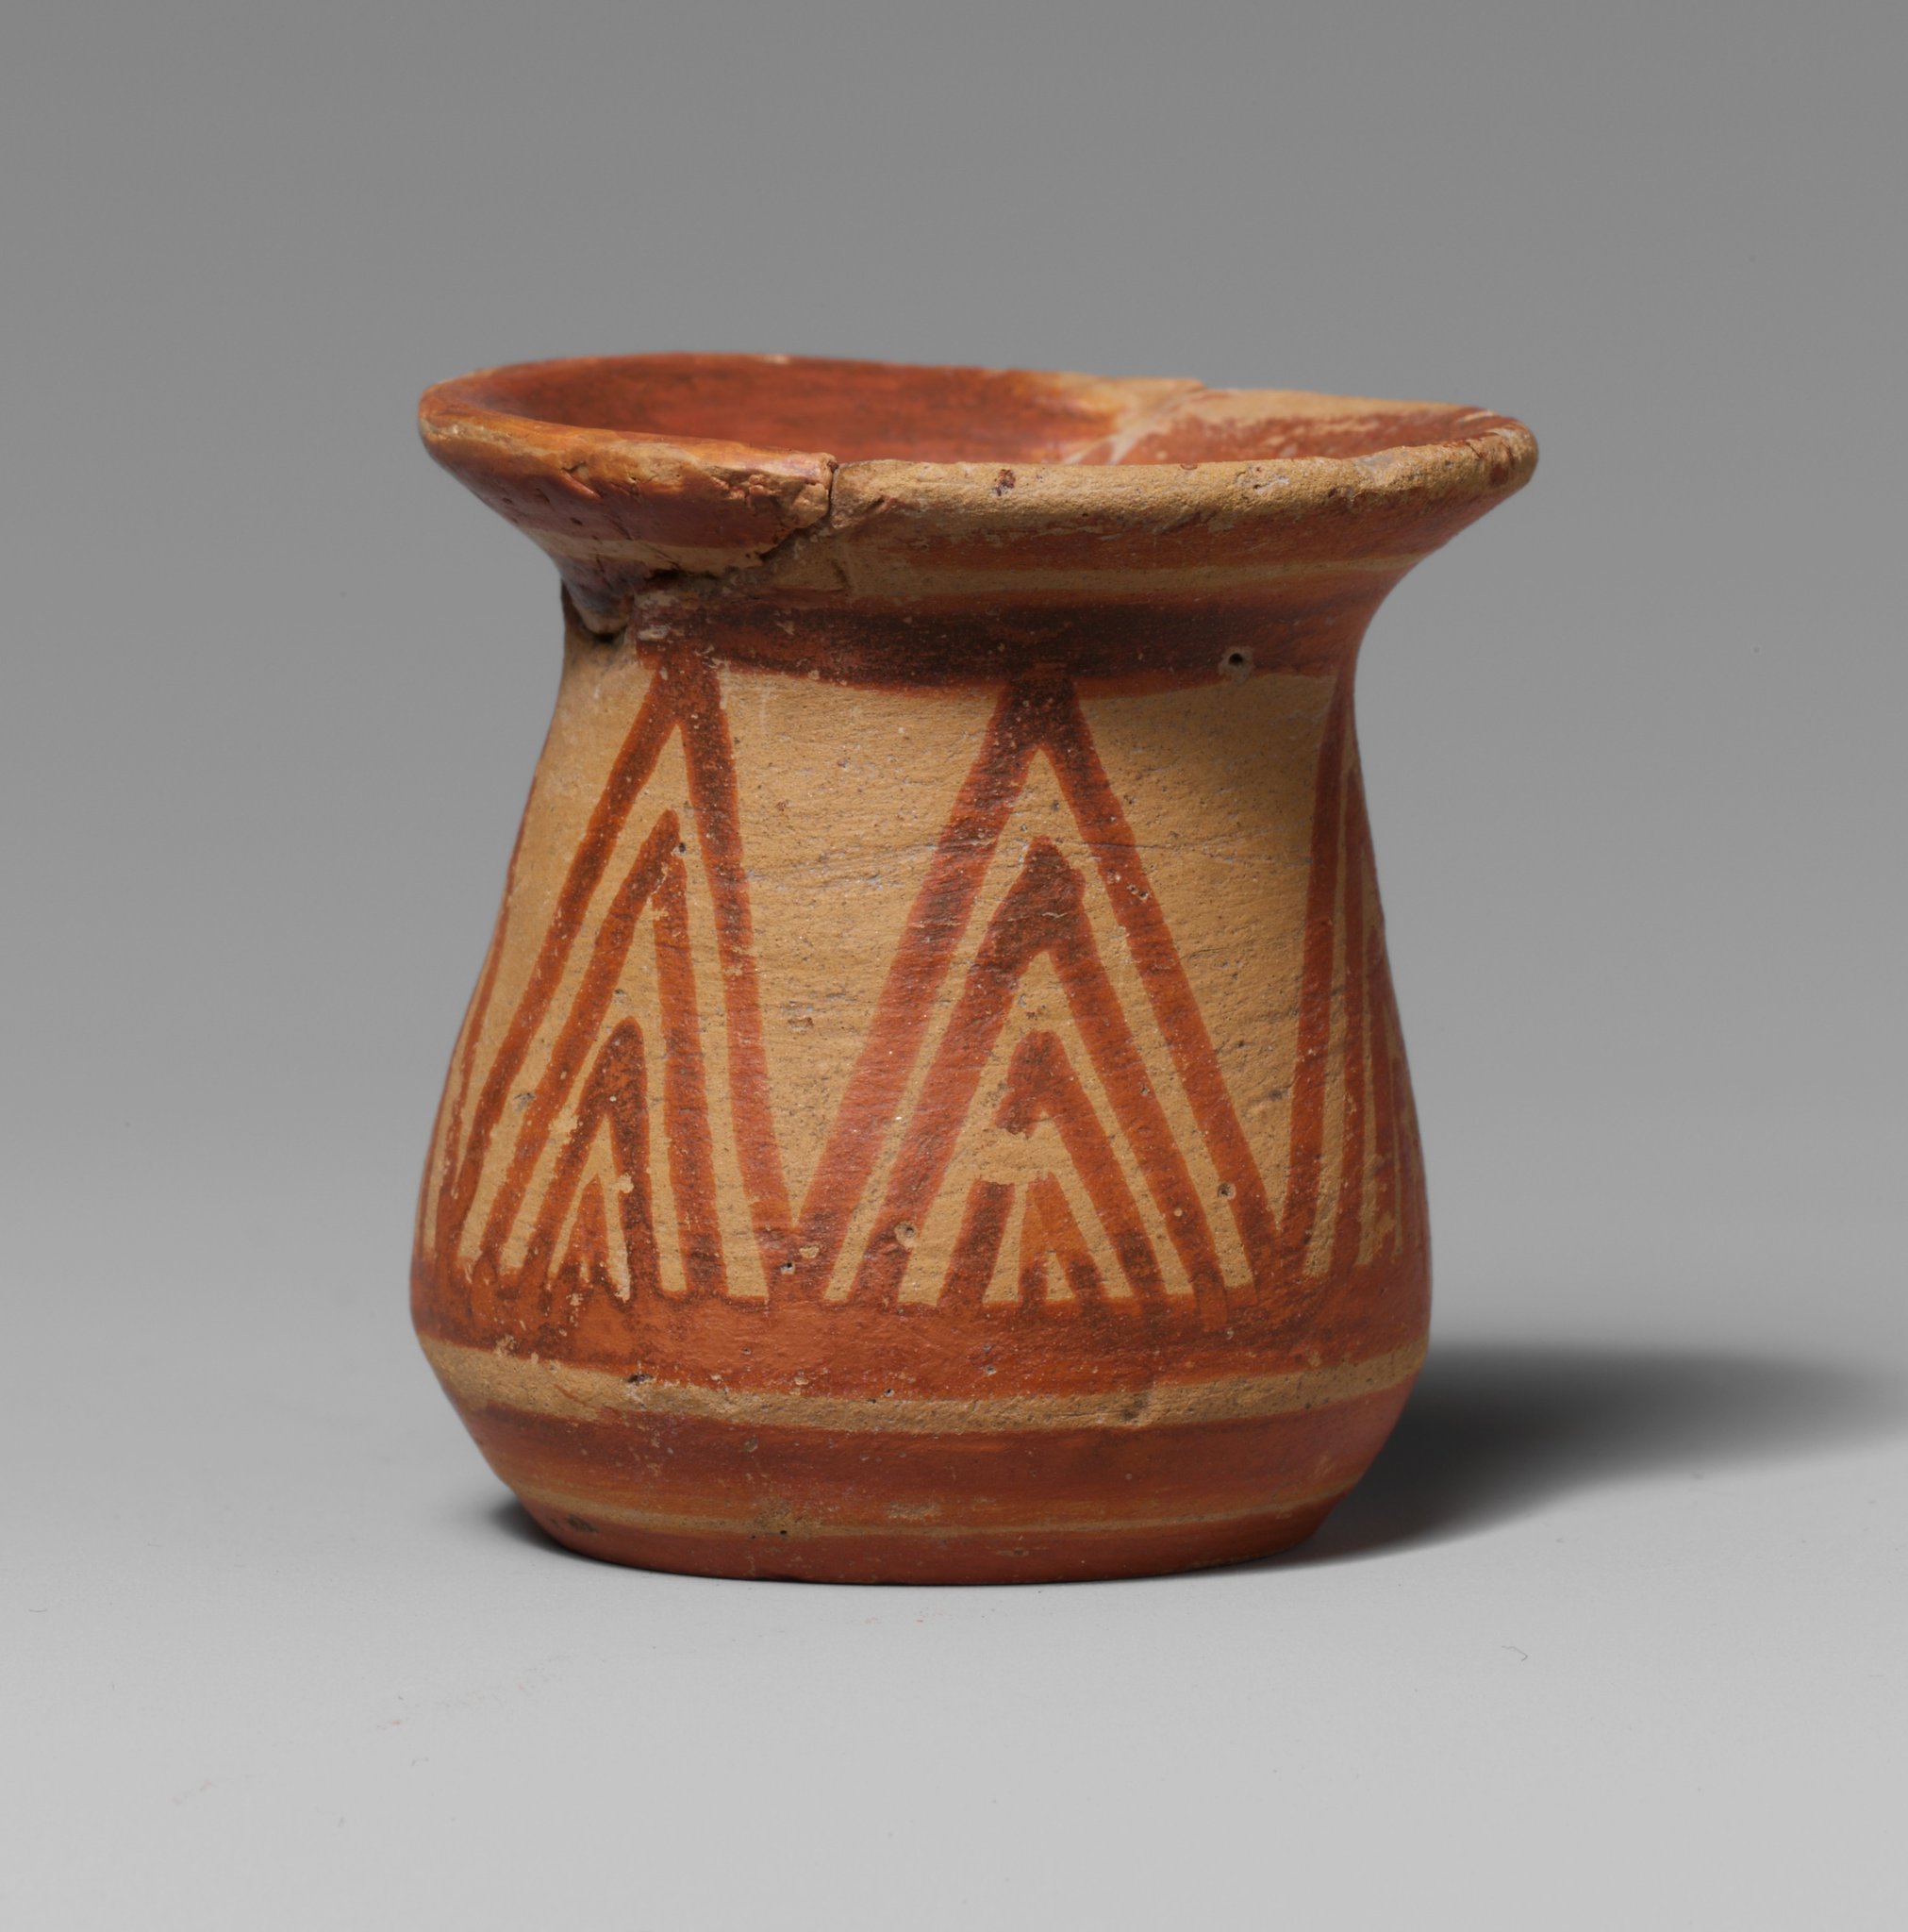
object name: jug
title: Terracotta juglet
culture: greek, attic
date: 800-701 BCE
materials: terracotta